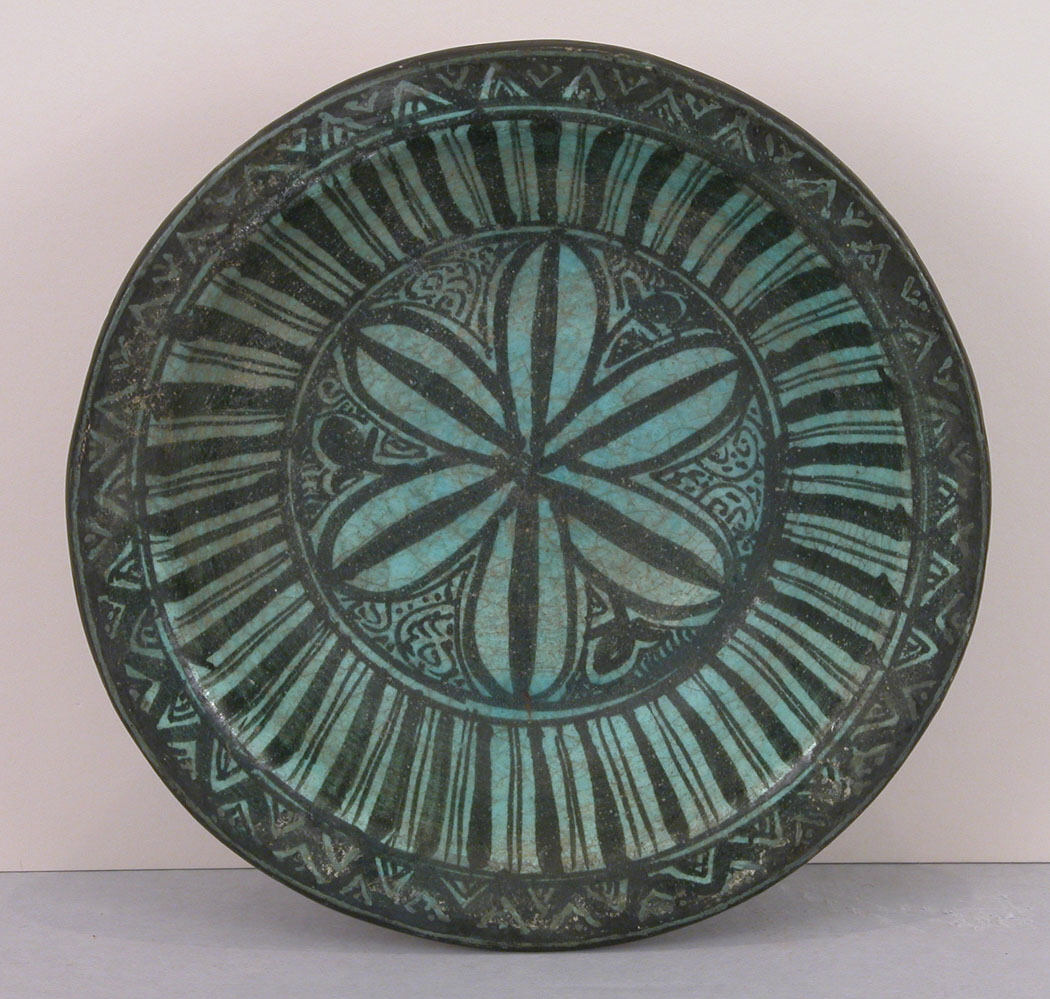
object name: bowl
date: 1301-1400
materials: stonepaste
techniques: painting, underglaze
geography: syria